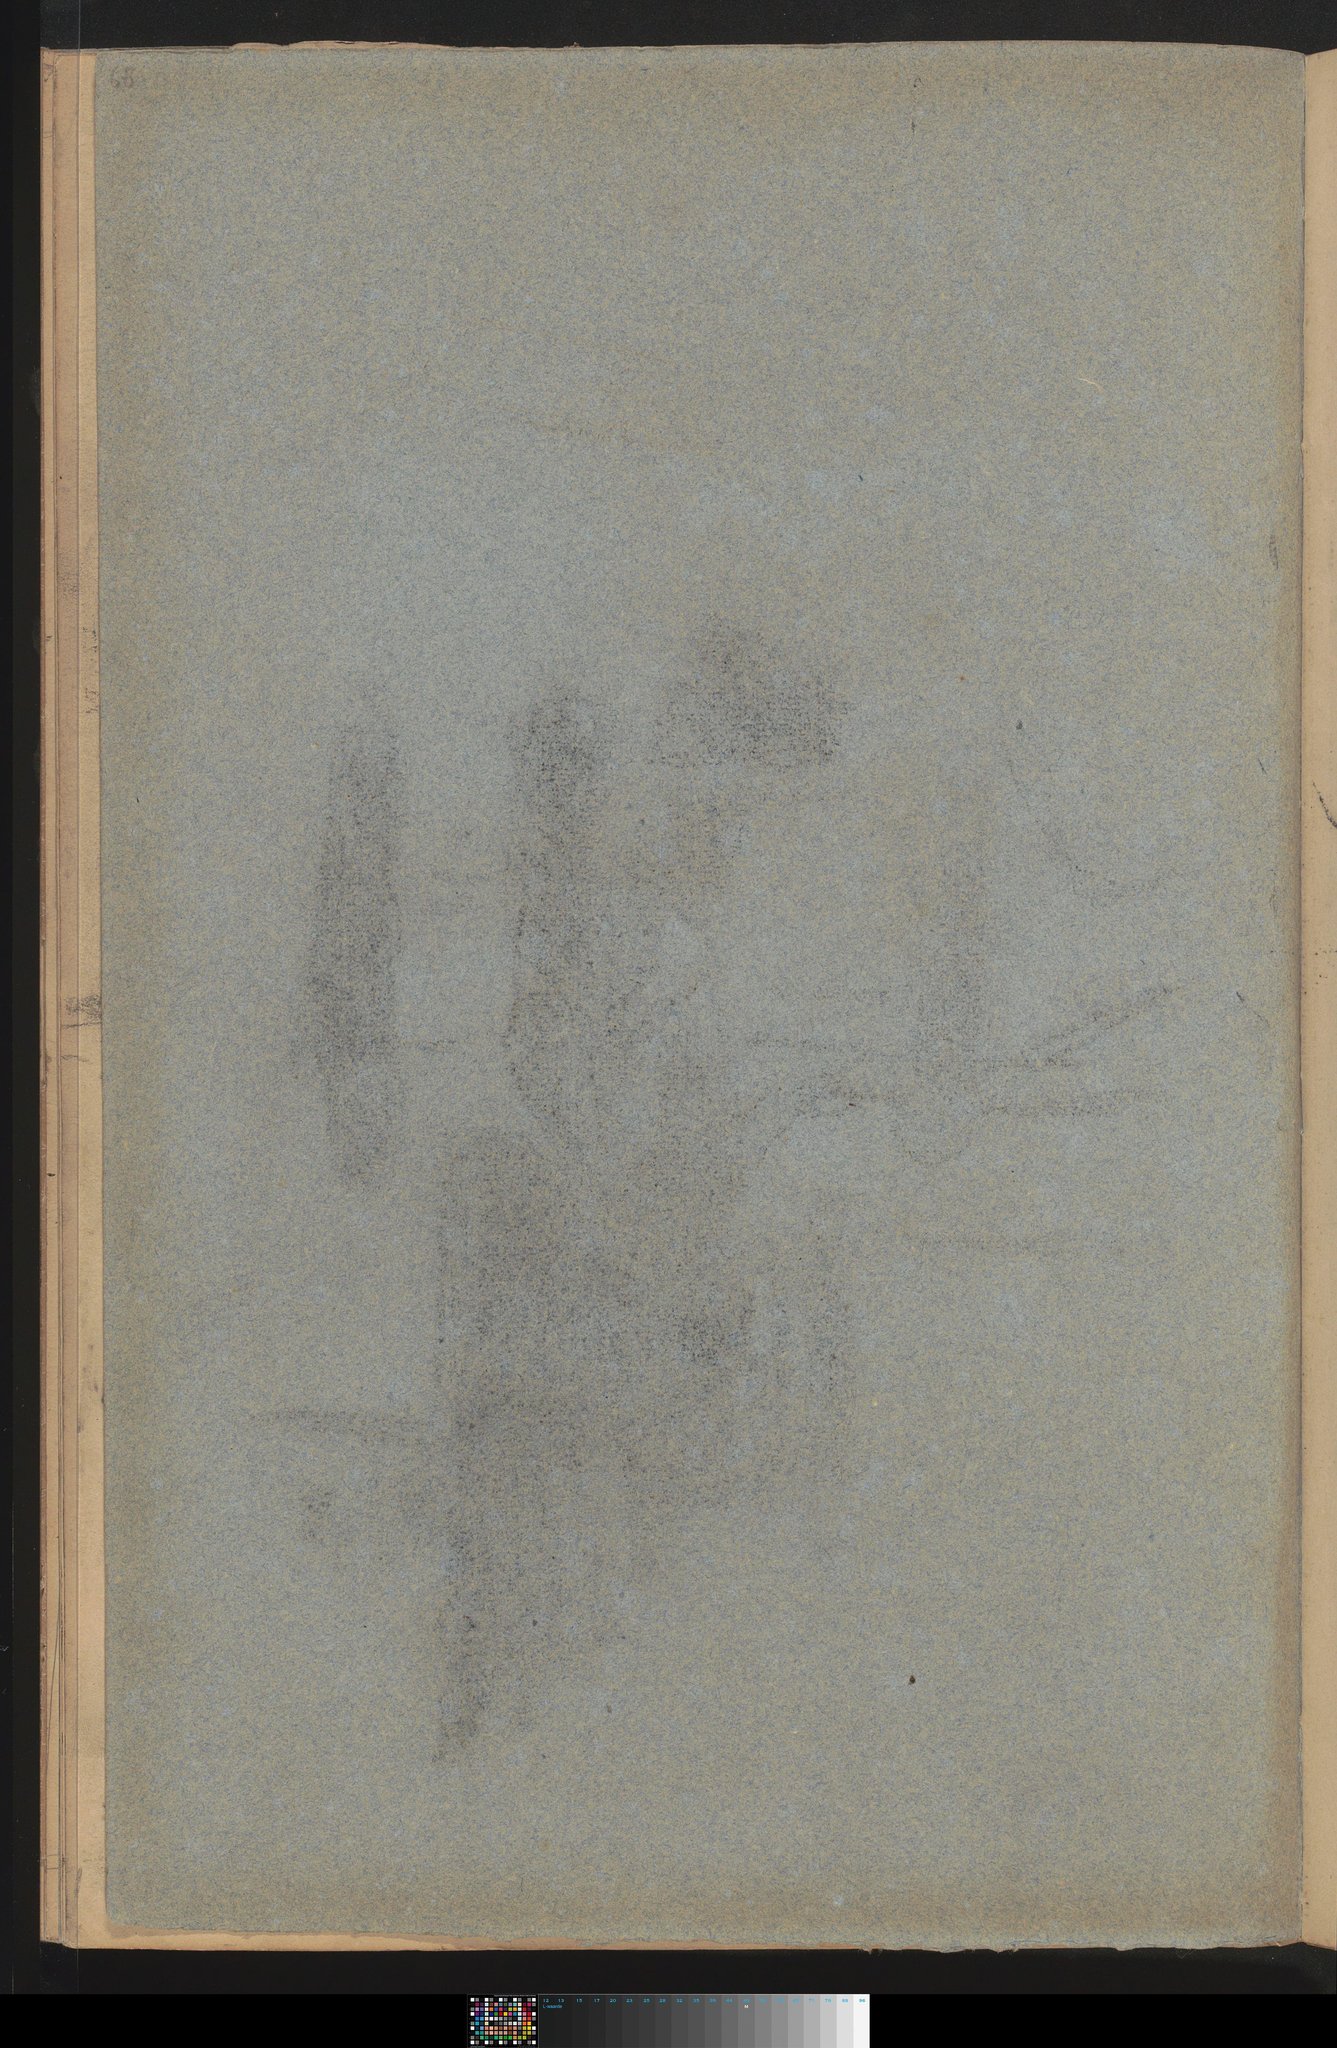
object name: sketchbook leaf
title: Abklatsch van de krijttekening op pagina 69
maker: willem witsen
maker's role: draughtsman, painter, print maker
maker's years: 1860-1923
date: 1884-1887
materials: paper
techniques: printmaking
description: Pagina 68 uit een schetsboek met 44 bladen.